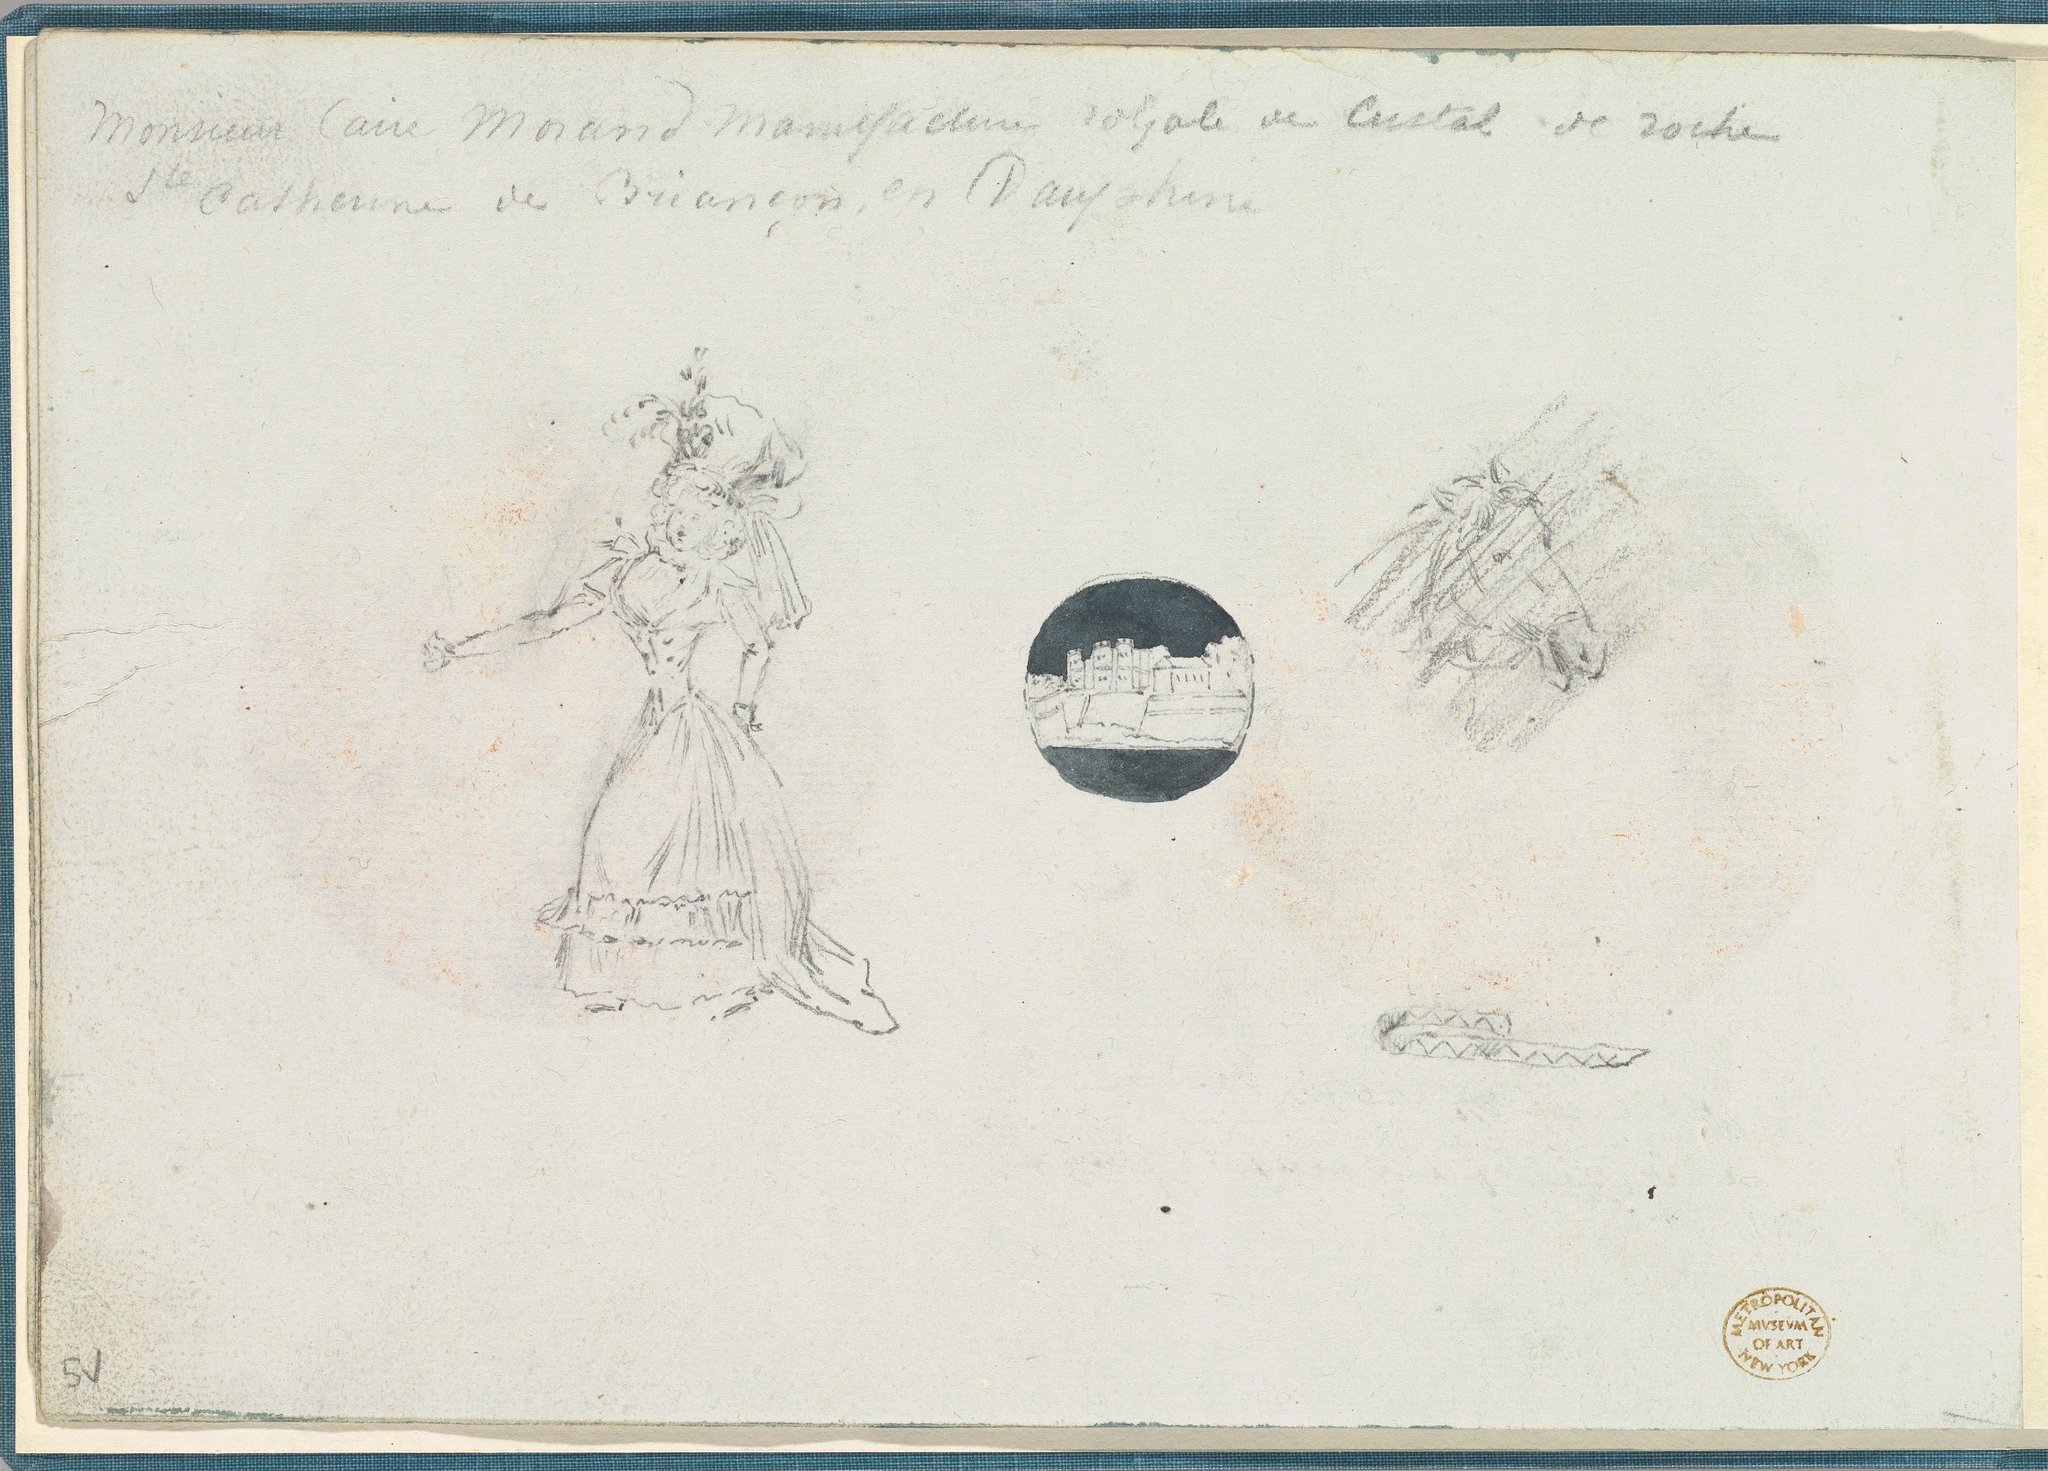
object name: collection ornament architecture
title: Sketches of a Woman in a Corseted Gown, a Castle, and a Horse's Head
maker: anonymous, french, 18th century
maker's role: artist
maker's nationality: french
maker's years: 1700-1800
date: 1785-1790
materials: gouache, graphite, ink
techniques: pen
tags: women,horses